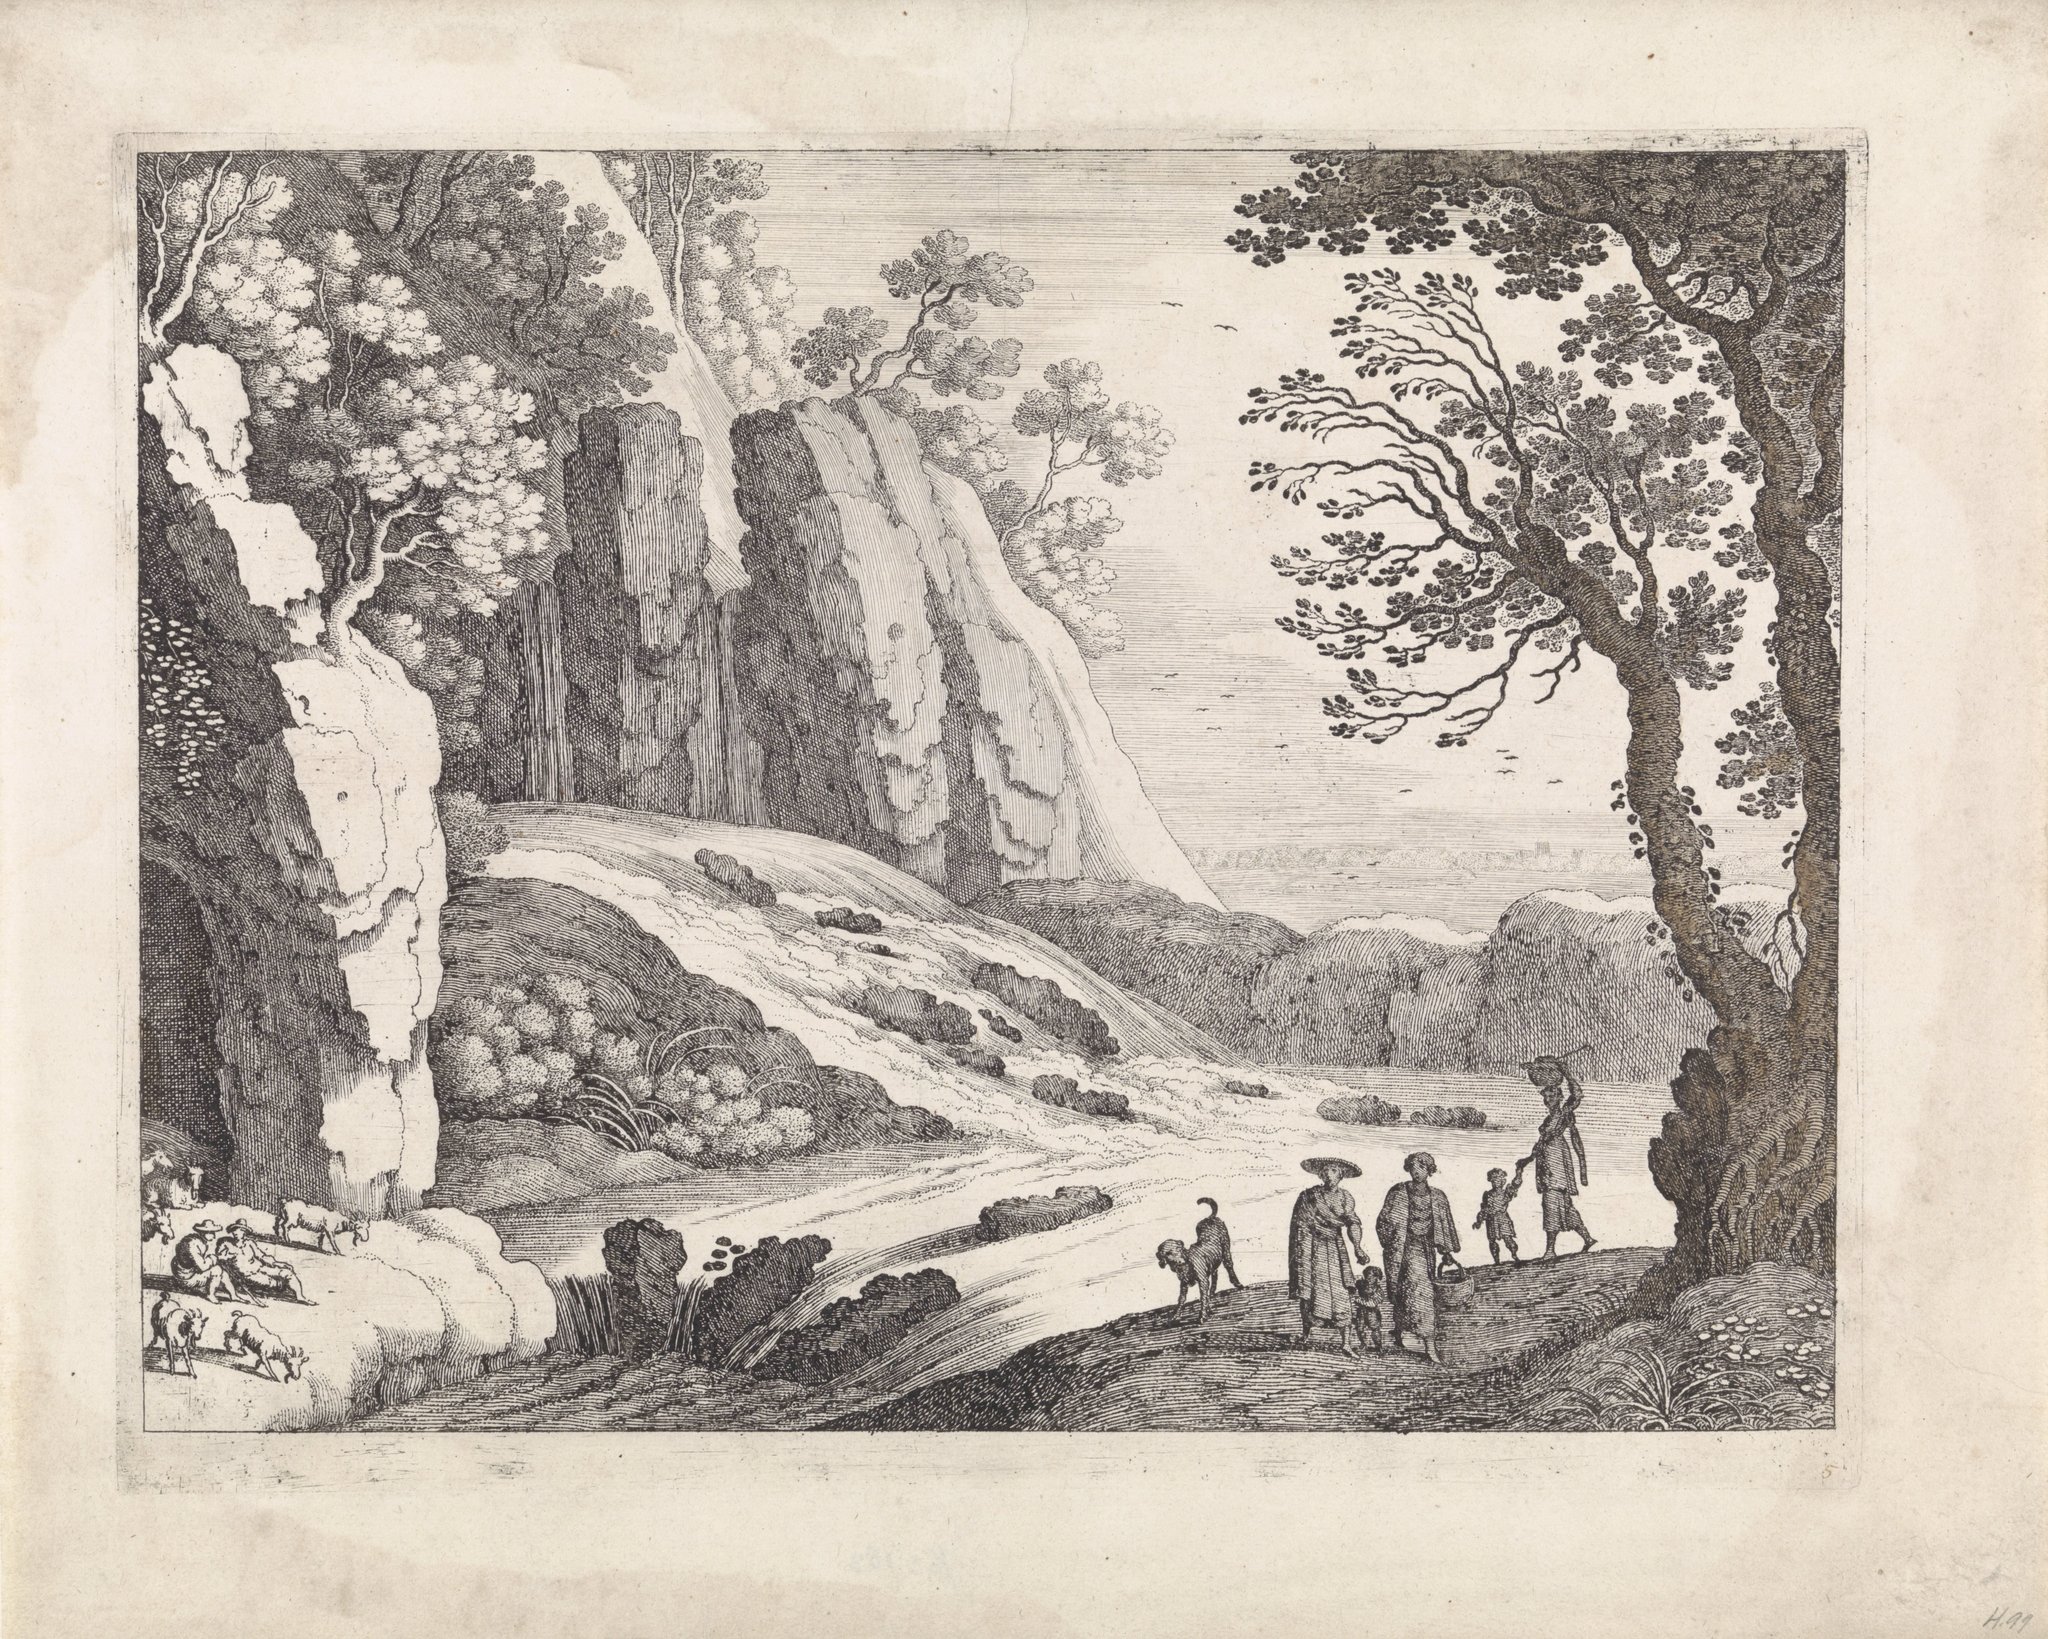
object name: print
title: Italiaanse landschappen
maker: guilliam van nieulandt (ii)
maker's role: draughtsman, print maker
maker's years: 1584-1635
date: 1594-1635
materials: paper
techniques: brush, engraving, etching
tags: herding, herdsman, herdswoman, shepherd, shepherdess, cowherd, etc., waterfall, goat, dog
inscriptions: collector's mark: Lugt 2760, collector's mark: Lugt 2228, inscription: ‘5’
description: Rechts voor een waterval drie vrouwen, twee kinderen en een hond. Links zitten twee herders met hun geiten. Prent uit een serie Italiaanse landschappen.